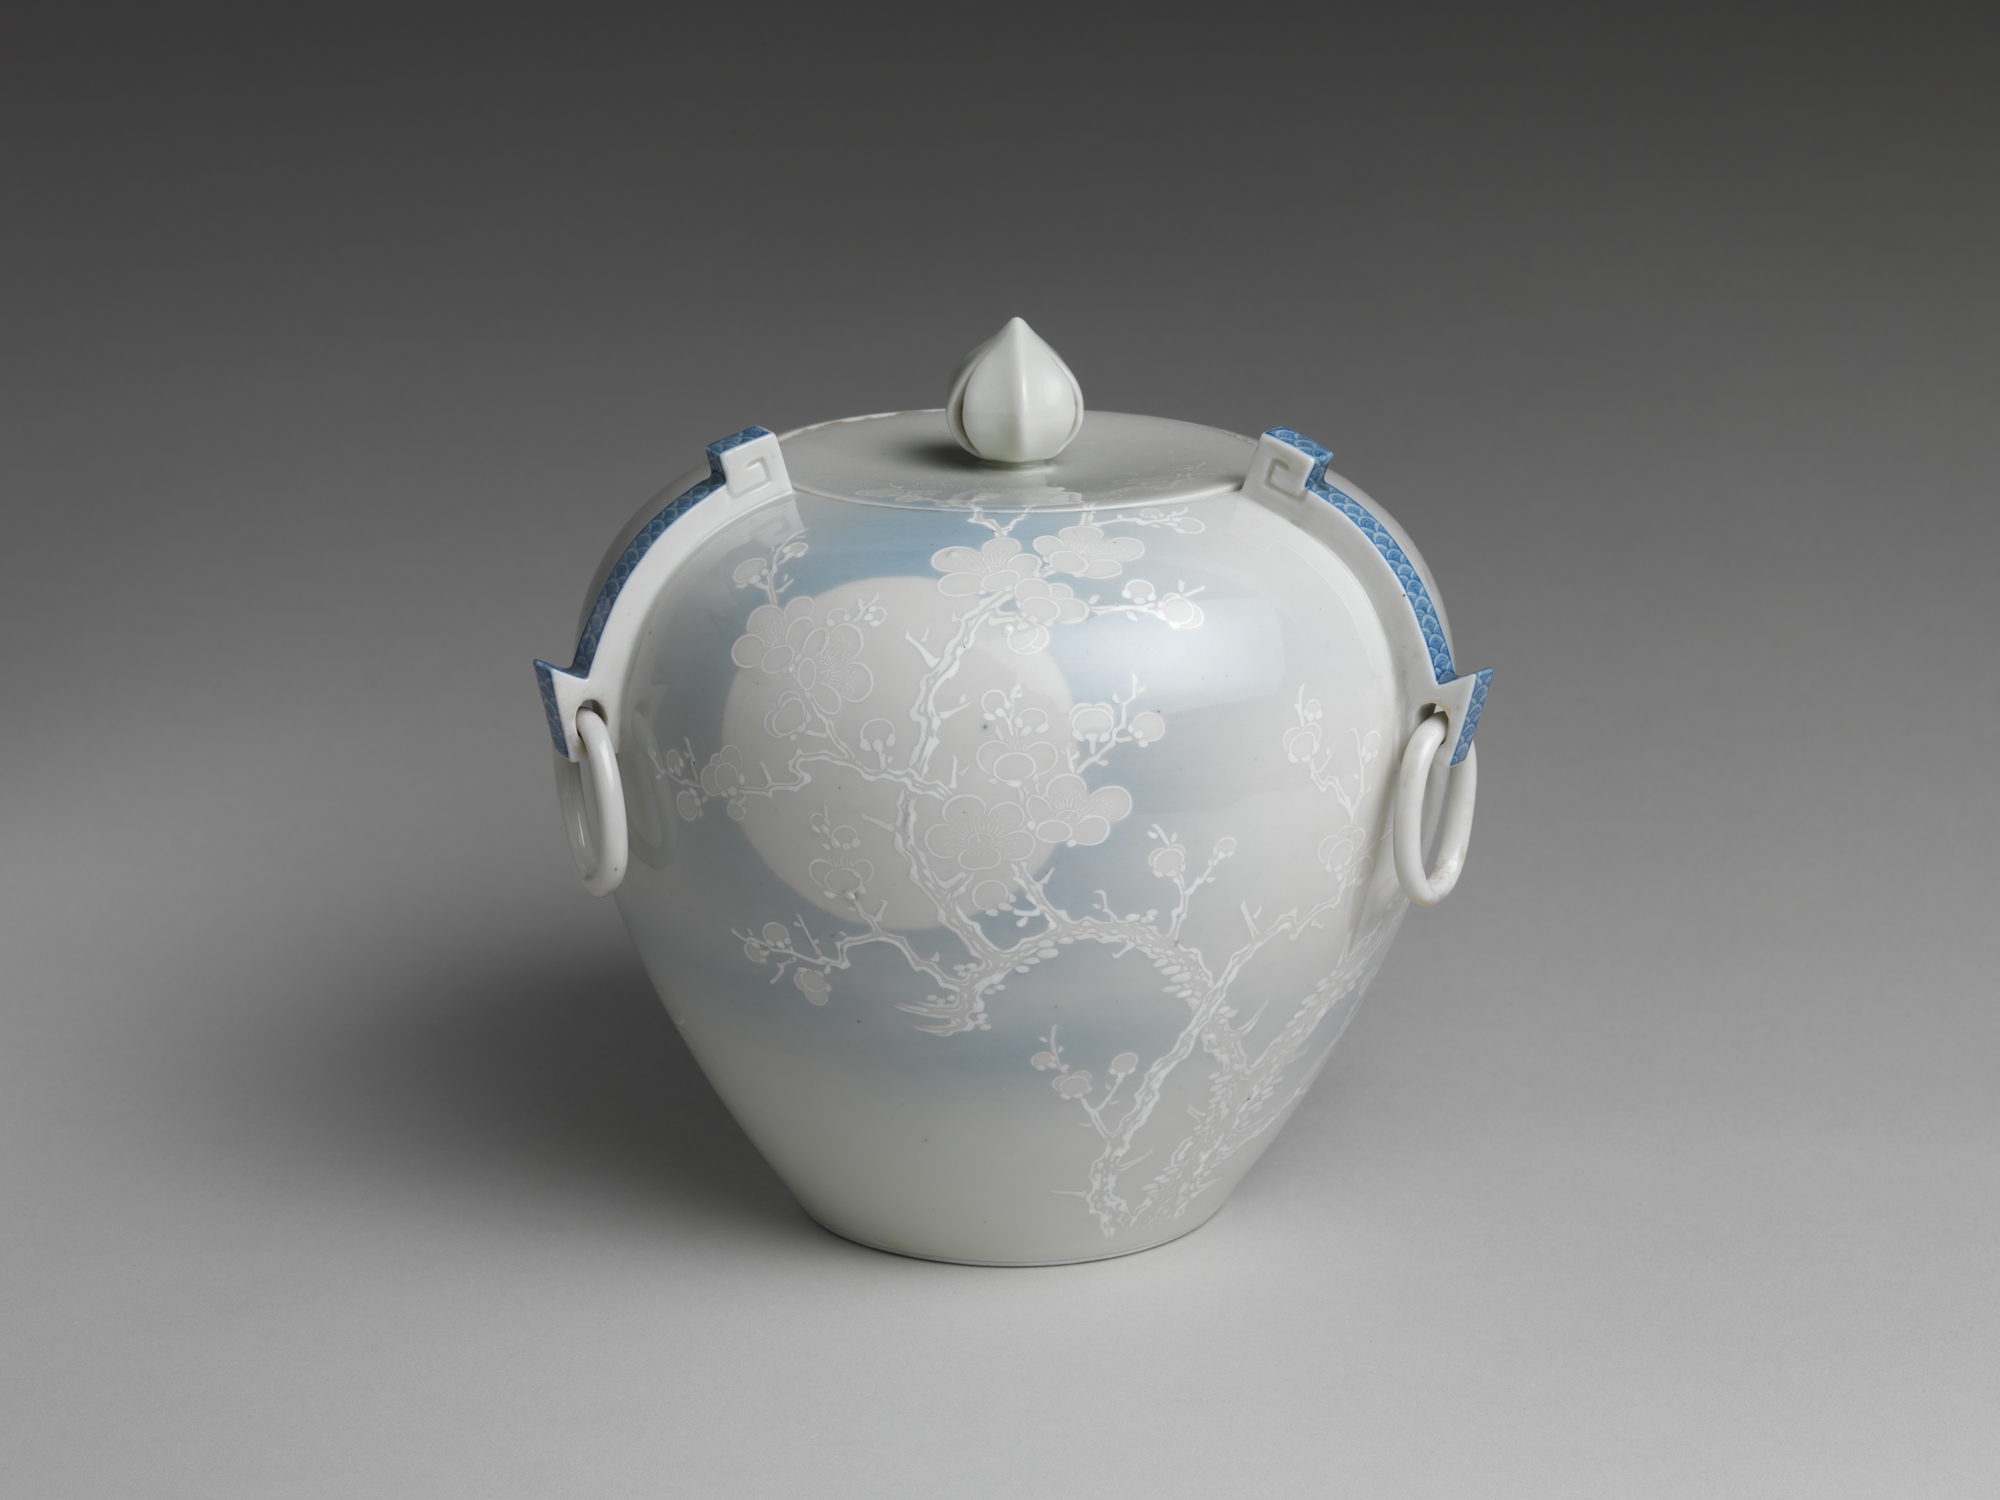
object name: covered pot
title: Water Jar with Plum Tree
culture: japanese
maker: katō tomotarō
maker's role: artist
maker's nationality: japanese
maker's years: 1851-1916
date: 1890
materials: ceramic glaze, glaze, porcelain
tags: flowers